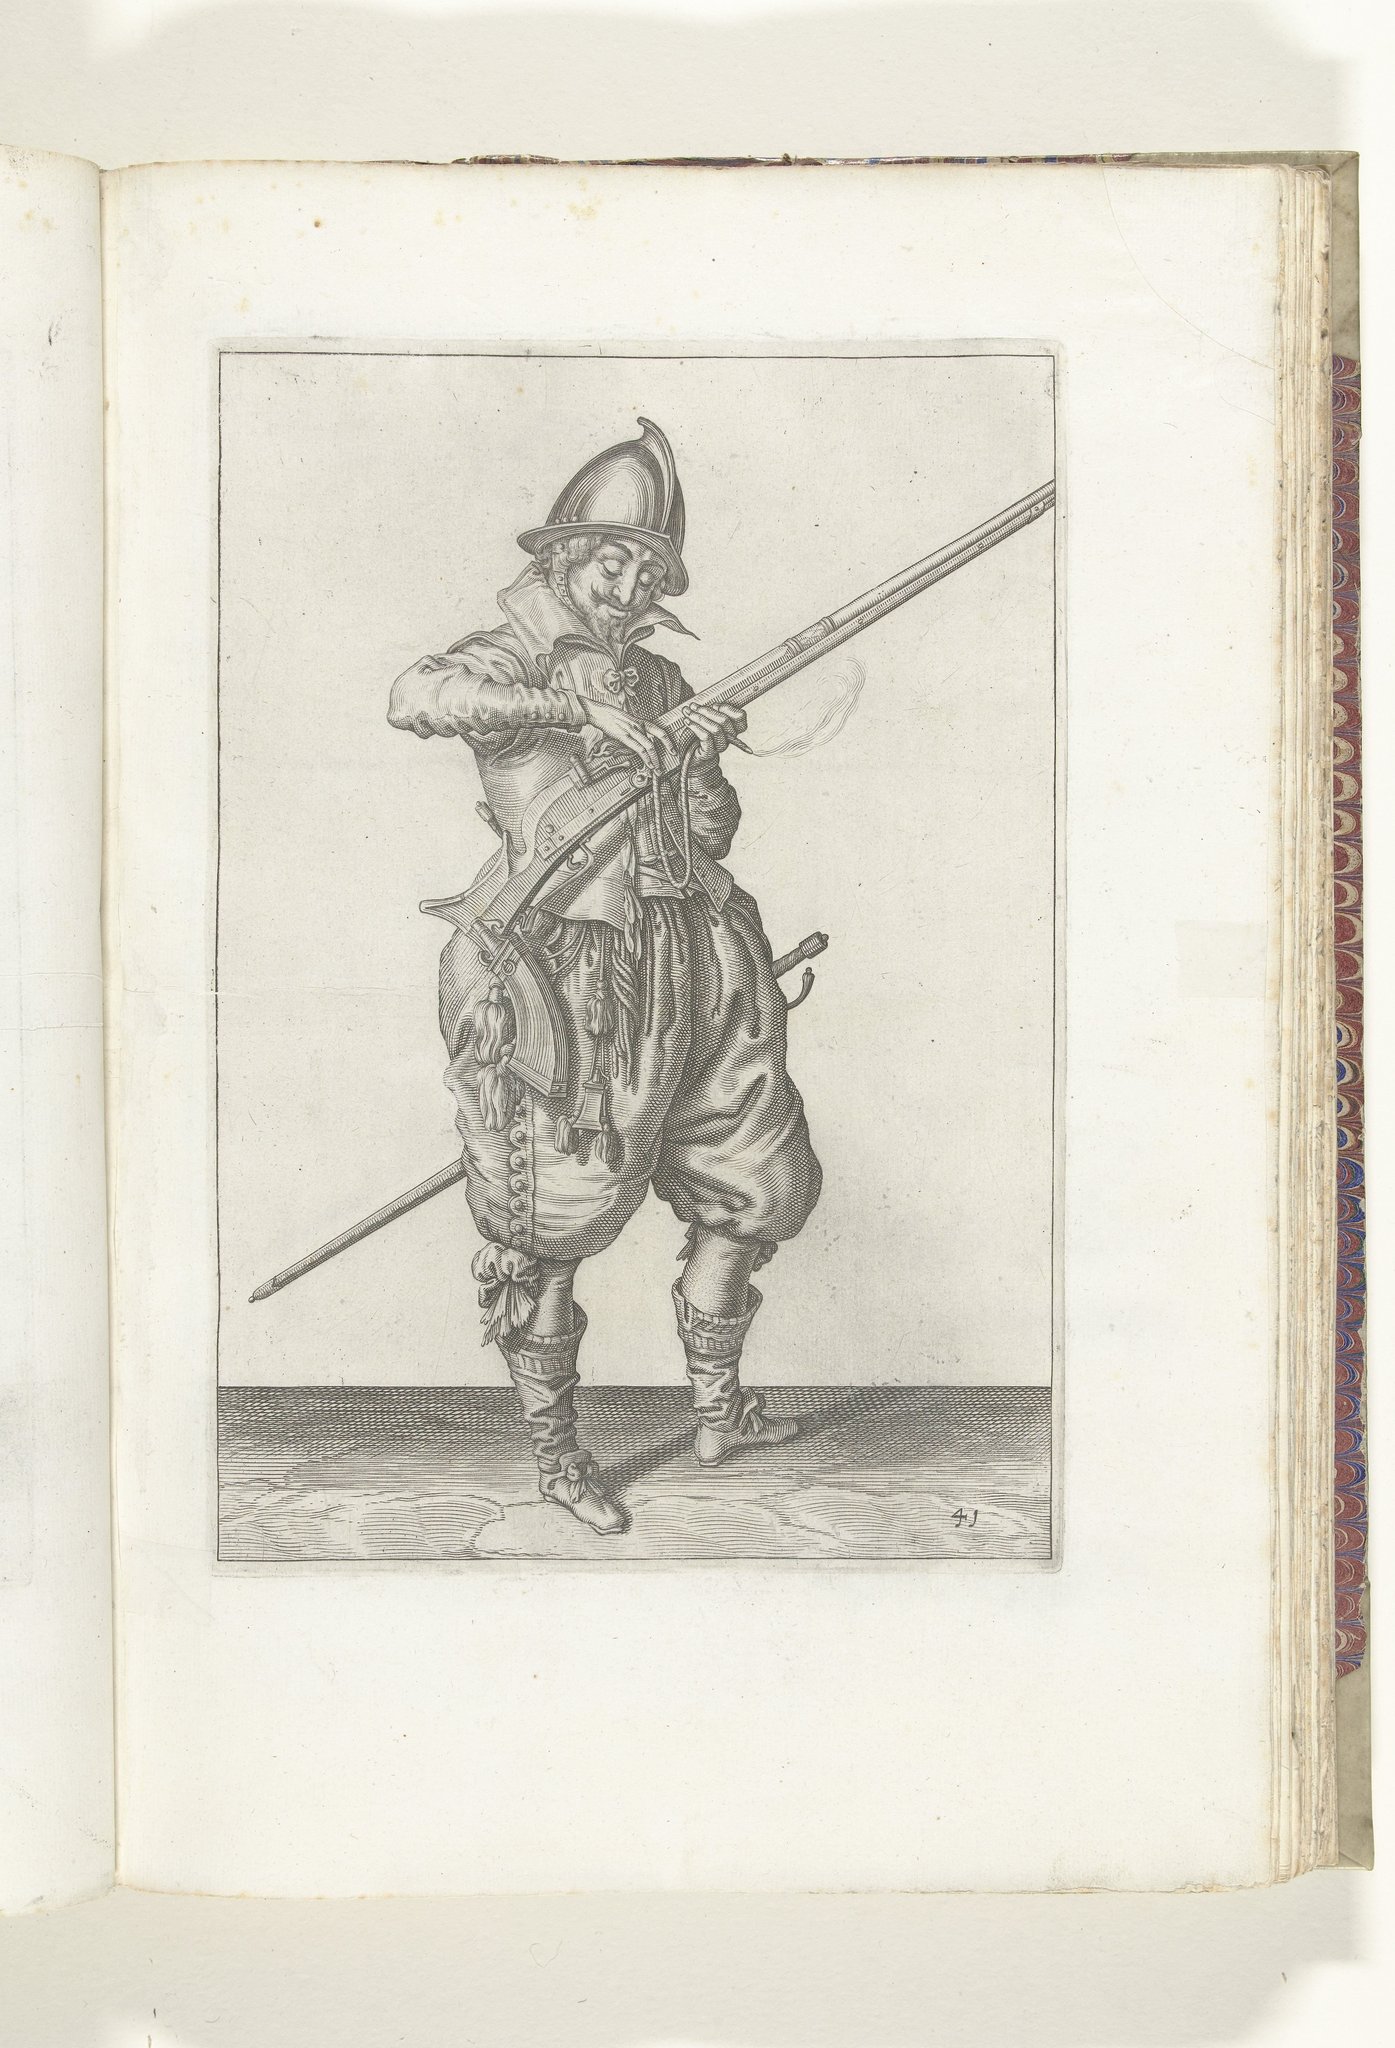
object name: print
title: Soldaat op wacht die de lont op de haan van zijn roer de juiste plek en vorm geeft (nr. 41), ca. 1600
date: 1597-1607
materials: paper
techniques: engraving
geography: northern netherlands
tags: the hague, maurice (prince of orange), handling of weapons ~ military training, weapons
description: Een soldaat op wacht, ten voeten uit, naar rechts, die een roer (een bepaald type vuurwapen) met zijn linkerhand vasthoudt (nr. 41), ca. 1600. Met duim en middelvinger van zijn rechterhand geeft hij de brandende lont op de haan (onderdeel van het ontstekingsmechanisme) van zijn roer de juiste plek en vorm. Het gaat dus om dezelfde positie als degene die op de achtste prent van de serie getoond wordt. Plaat 41 in de instructies voor het hanteren van de roer. Onderdeel van de illustraties in: J. de Gheyn, Wapenhandelinghe van Roers Musquetten ende spiessen, Amsterdam, 1608. Krijgswezen rond 1600.